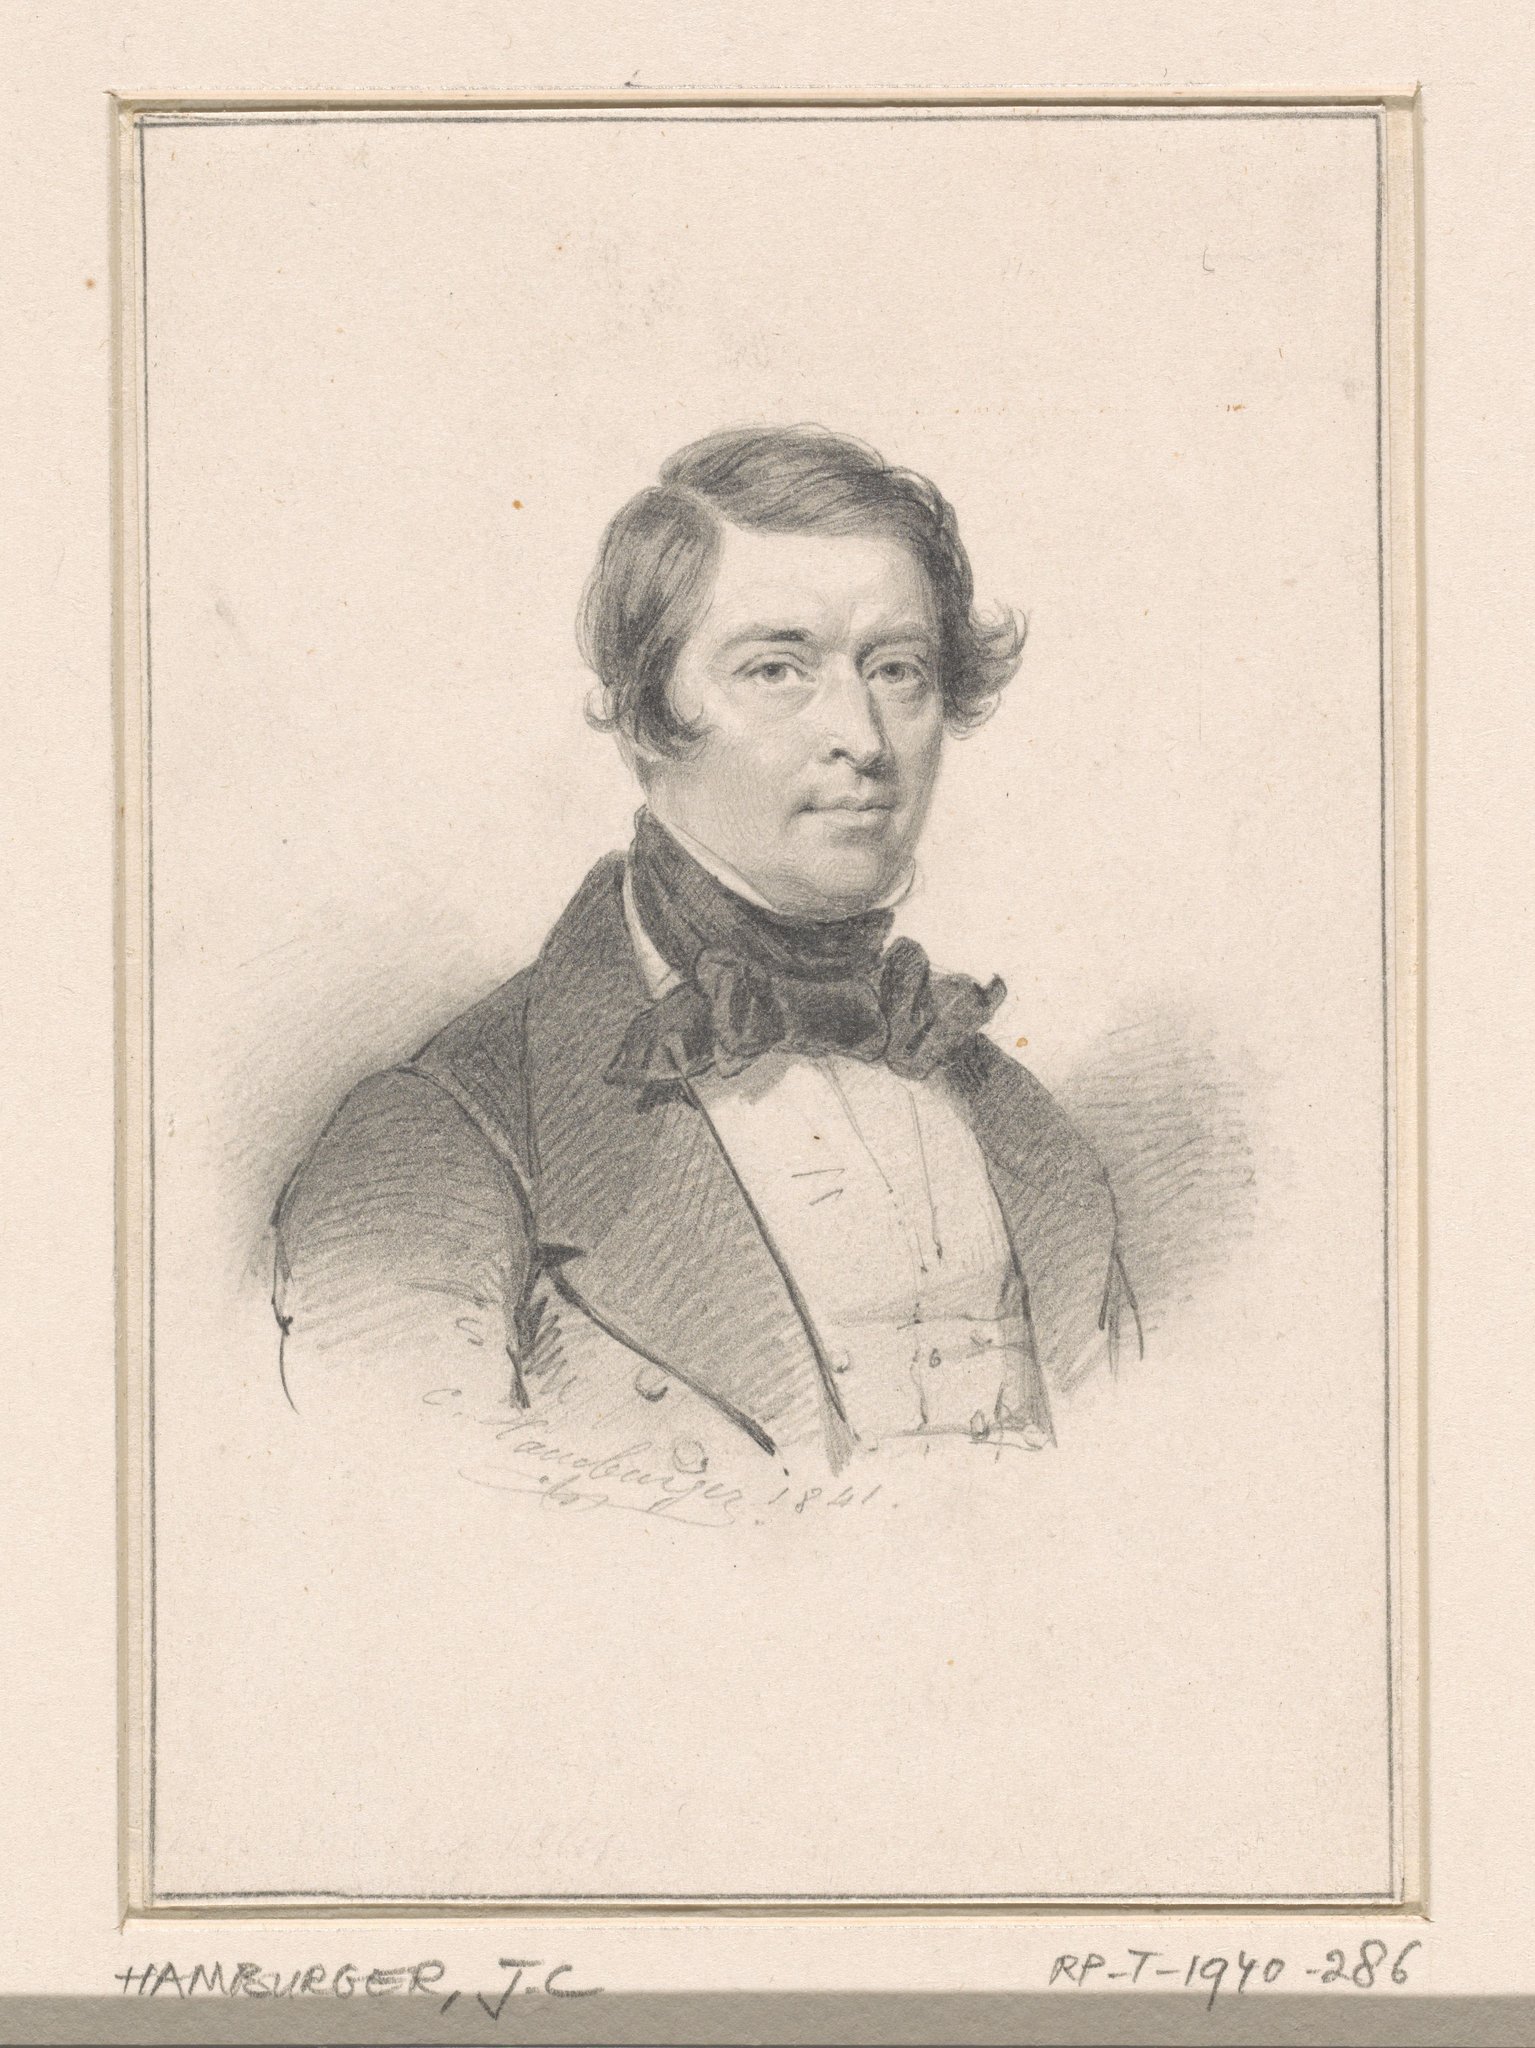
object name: print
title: Portret van Cornelis Lieste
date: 1852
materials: paper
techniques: tone lithography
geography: netherlands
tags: haarlem, cornelis lieste, historical persons, portrait, self-portrait of graphic artist, portrait, self-portrait of draughtsman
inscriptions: collector's mark: Lugt 2760, collector's mark: Lugt 2228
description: Prent waarschijnlijk uit: Album der Schoone Kunsten. Romantiesch, kritisch en historisch tijdschrift (...) (1852).